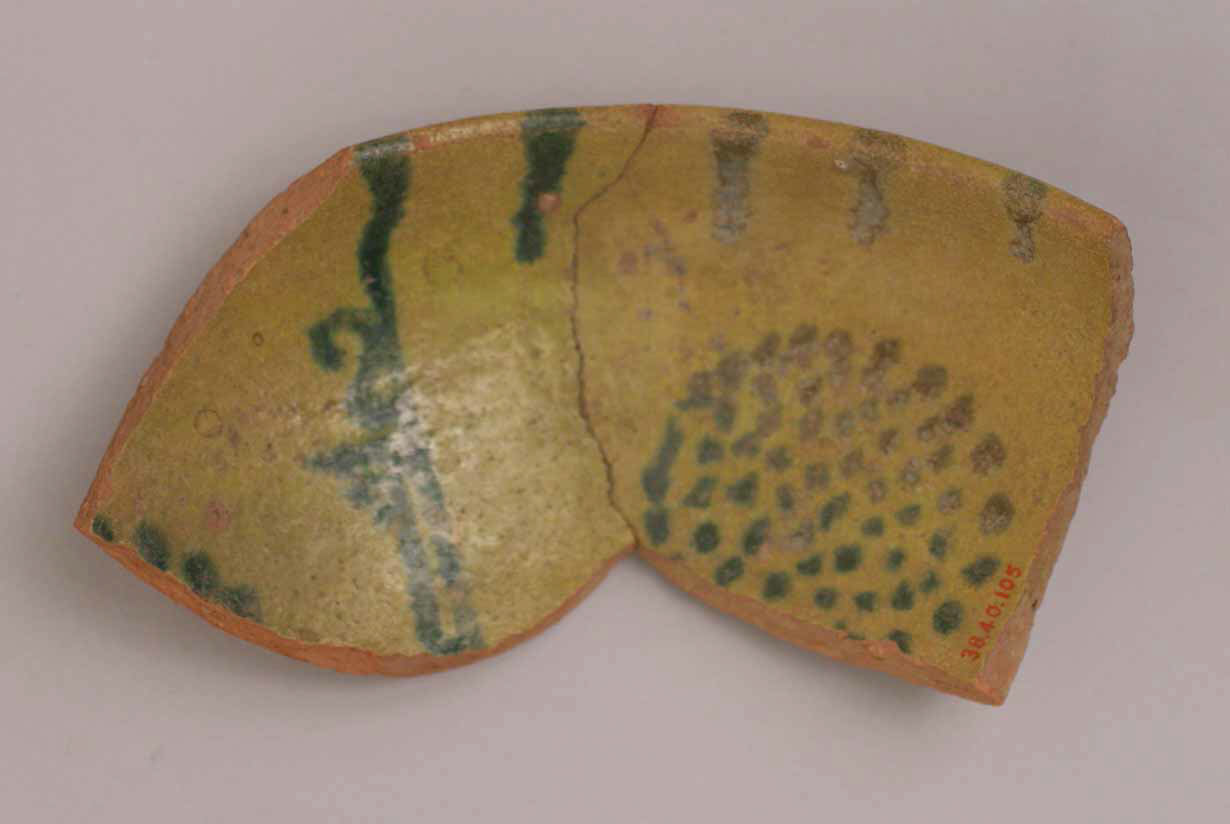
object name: fragment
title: Fragment of a Bowl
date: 801-833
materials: earthenware, glaze, pigment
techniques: painting, underglaze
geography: iran